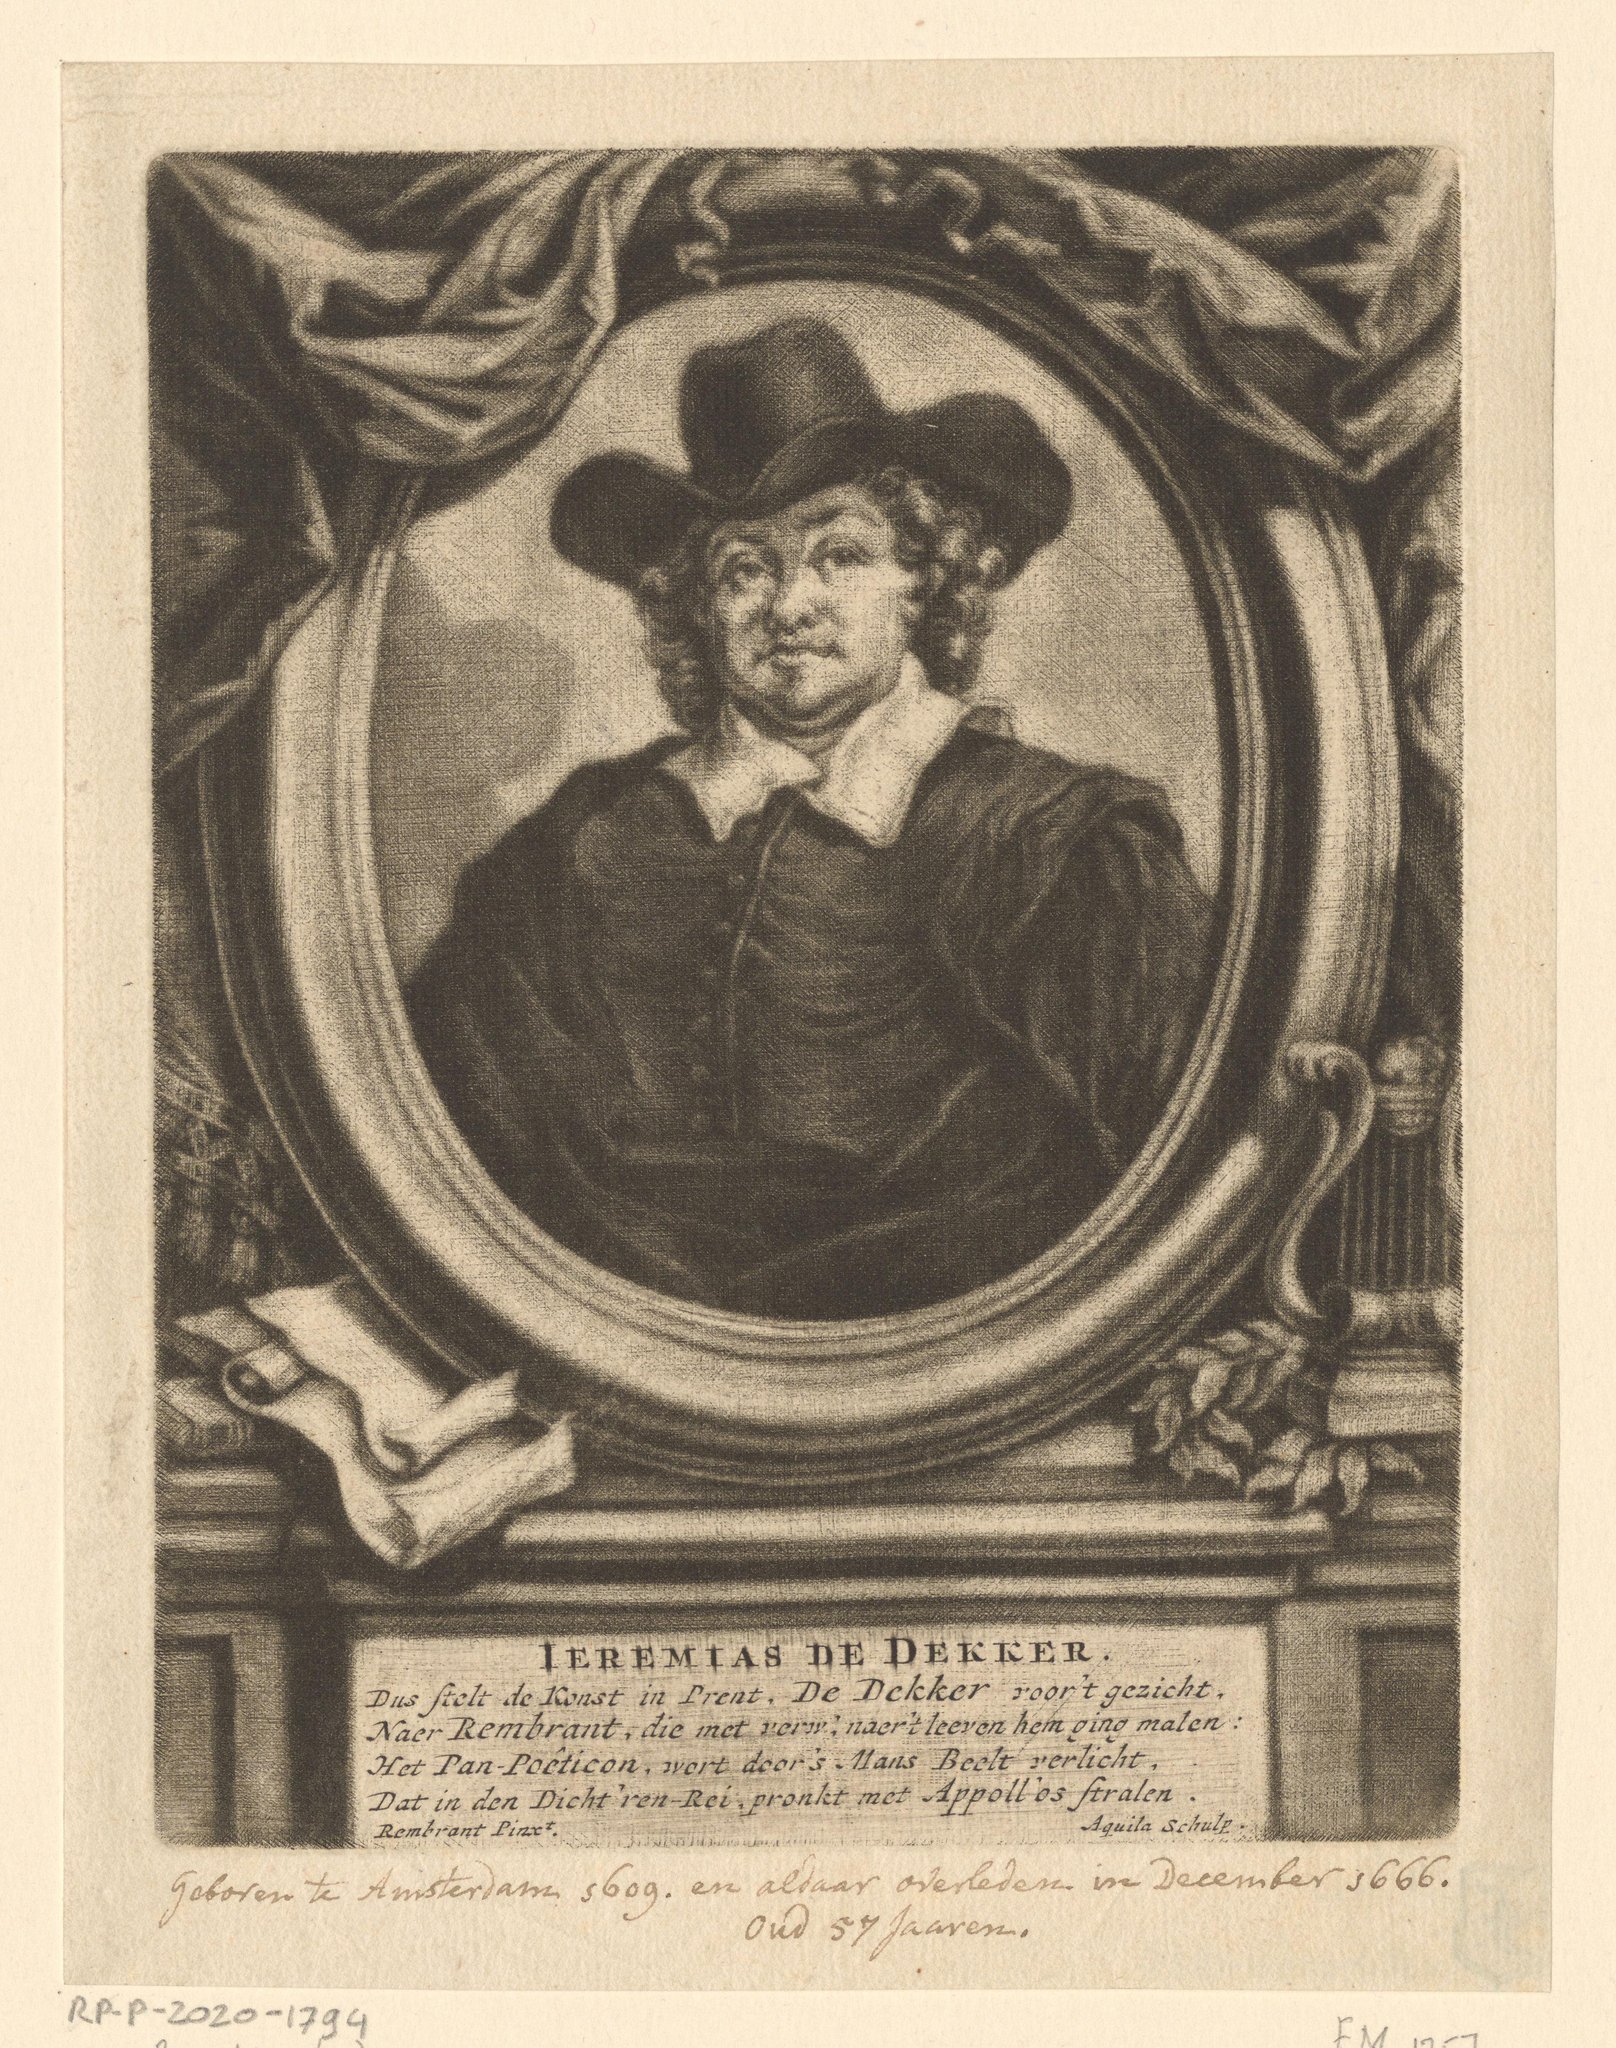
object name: print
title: Portret van Jeremias de Decker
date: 1700-1723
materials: paper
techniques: engraving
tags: dordrecht, jeremias de decker, historical persons, portrait of a writer, head-gear: hat, writer, poet, author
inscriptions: collector's mark: Lugt 963, inscription: ‘geboren te Amsterdam 1609. en aldaar overleden (...)’